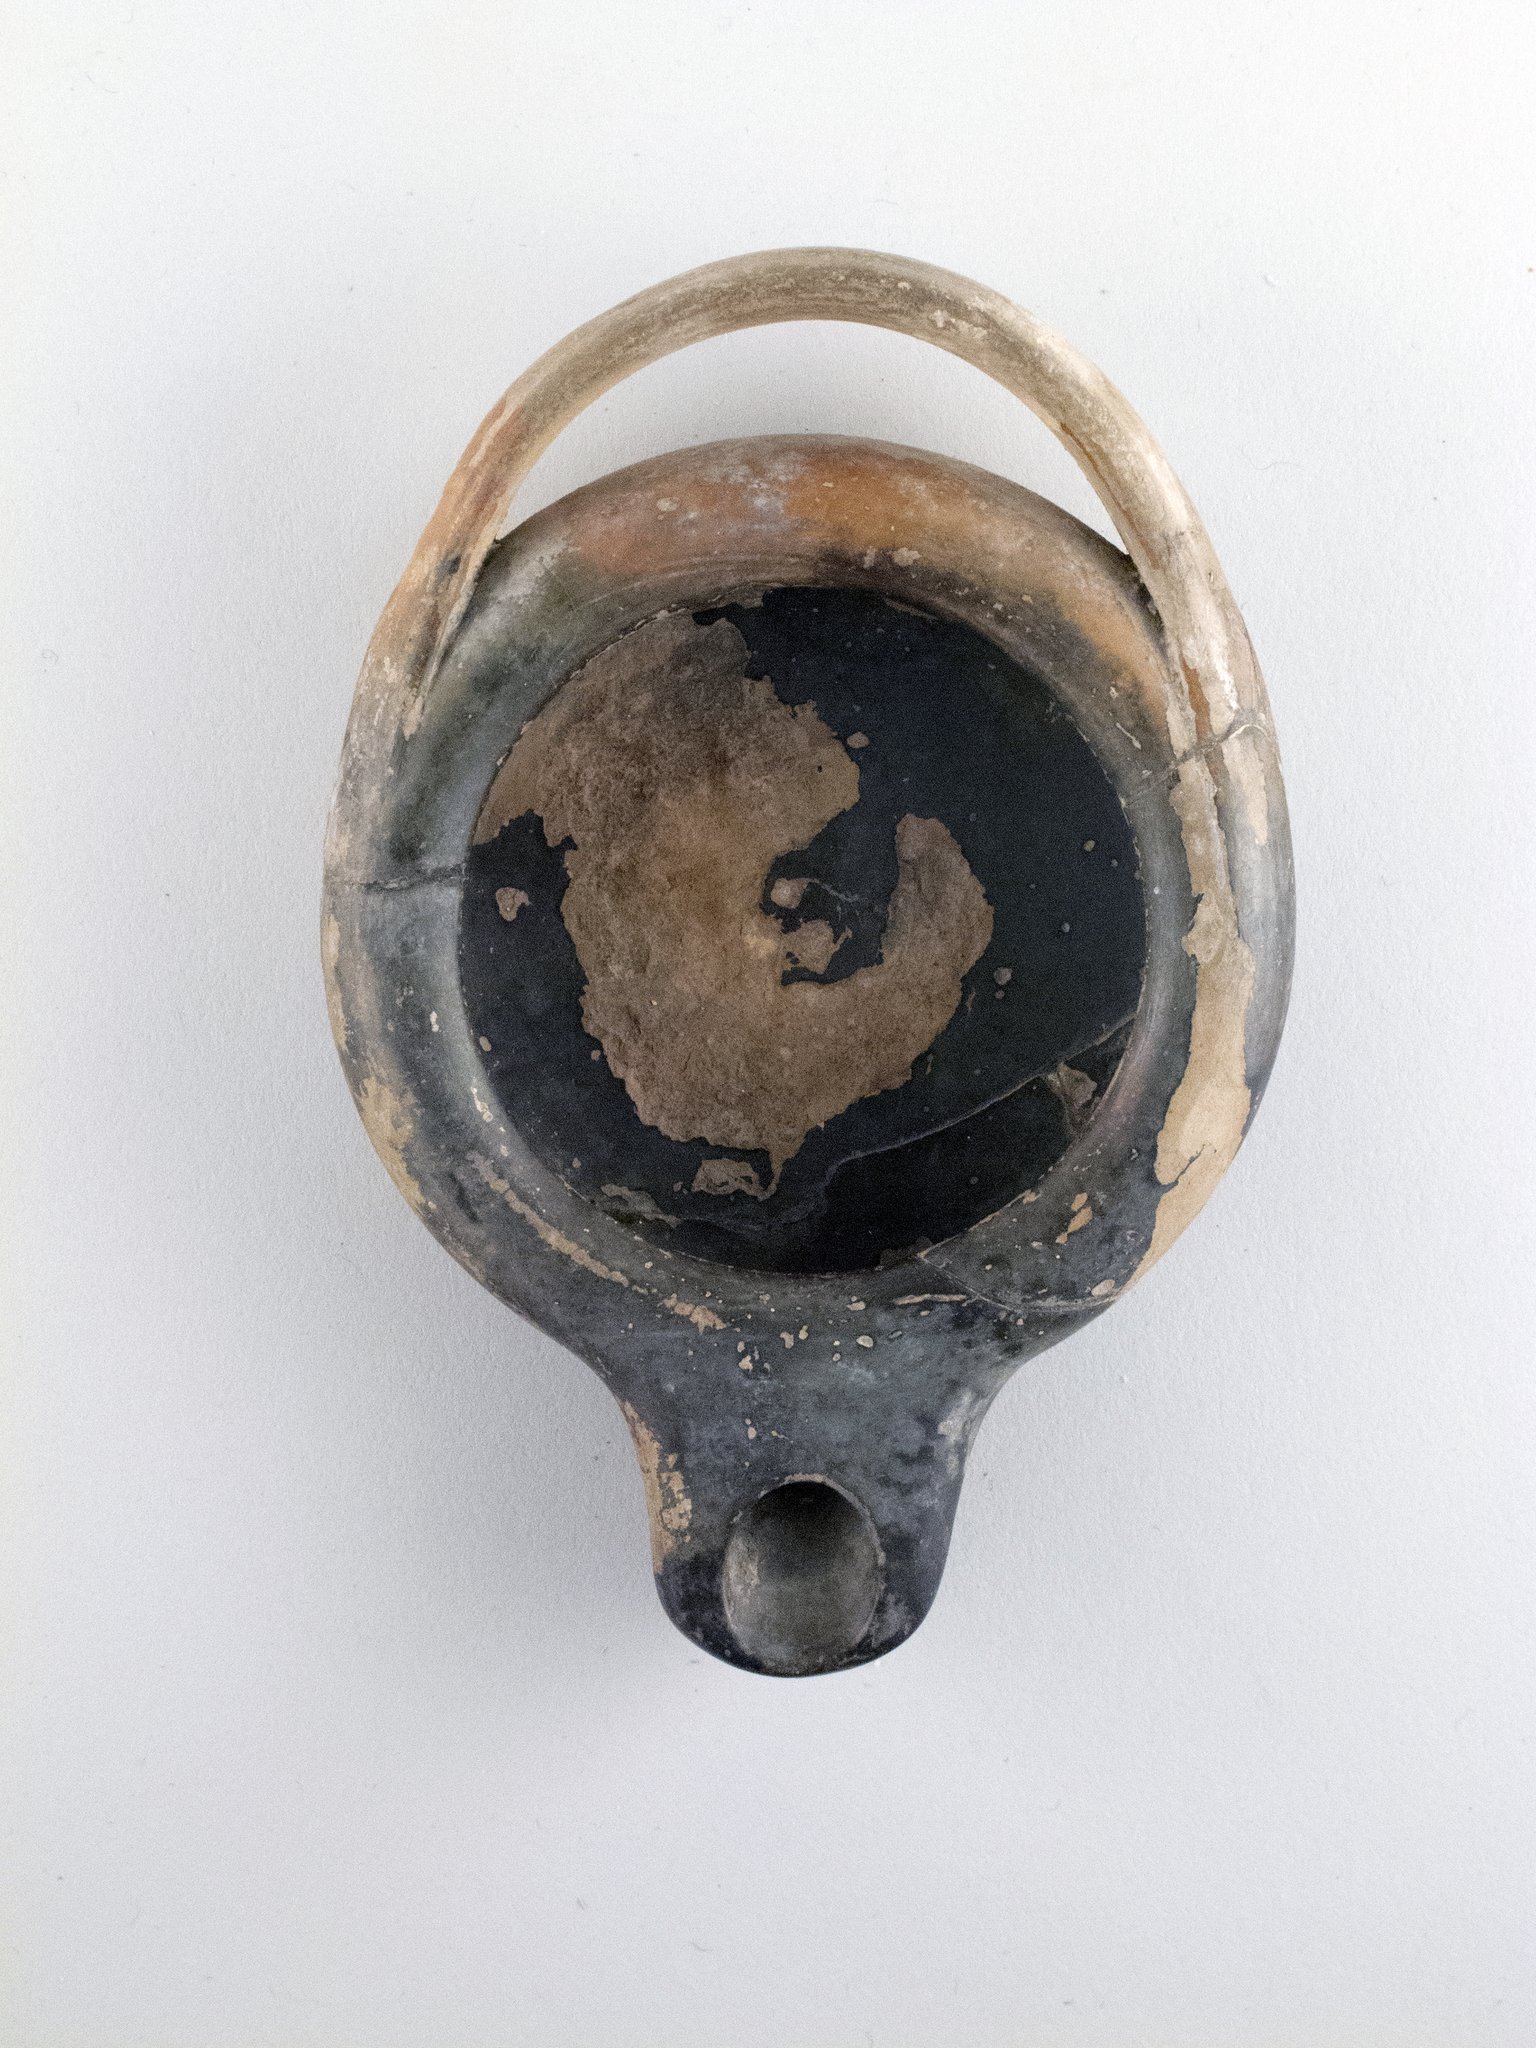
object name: lamp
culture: greek, attic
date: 500-401 BCE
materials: terracotta